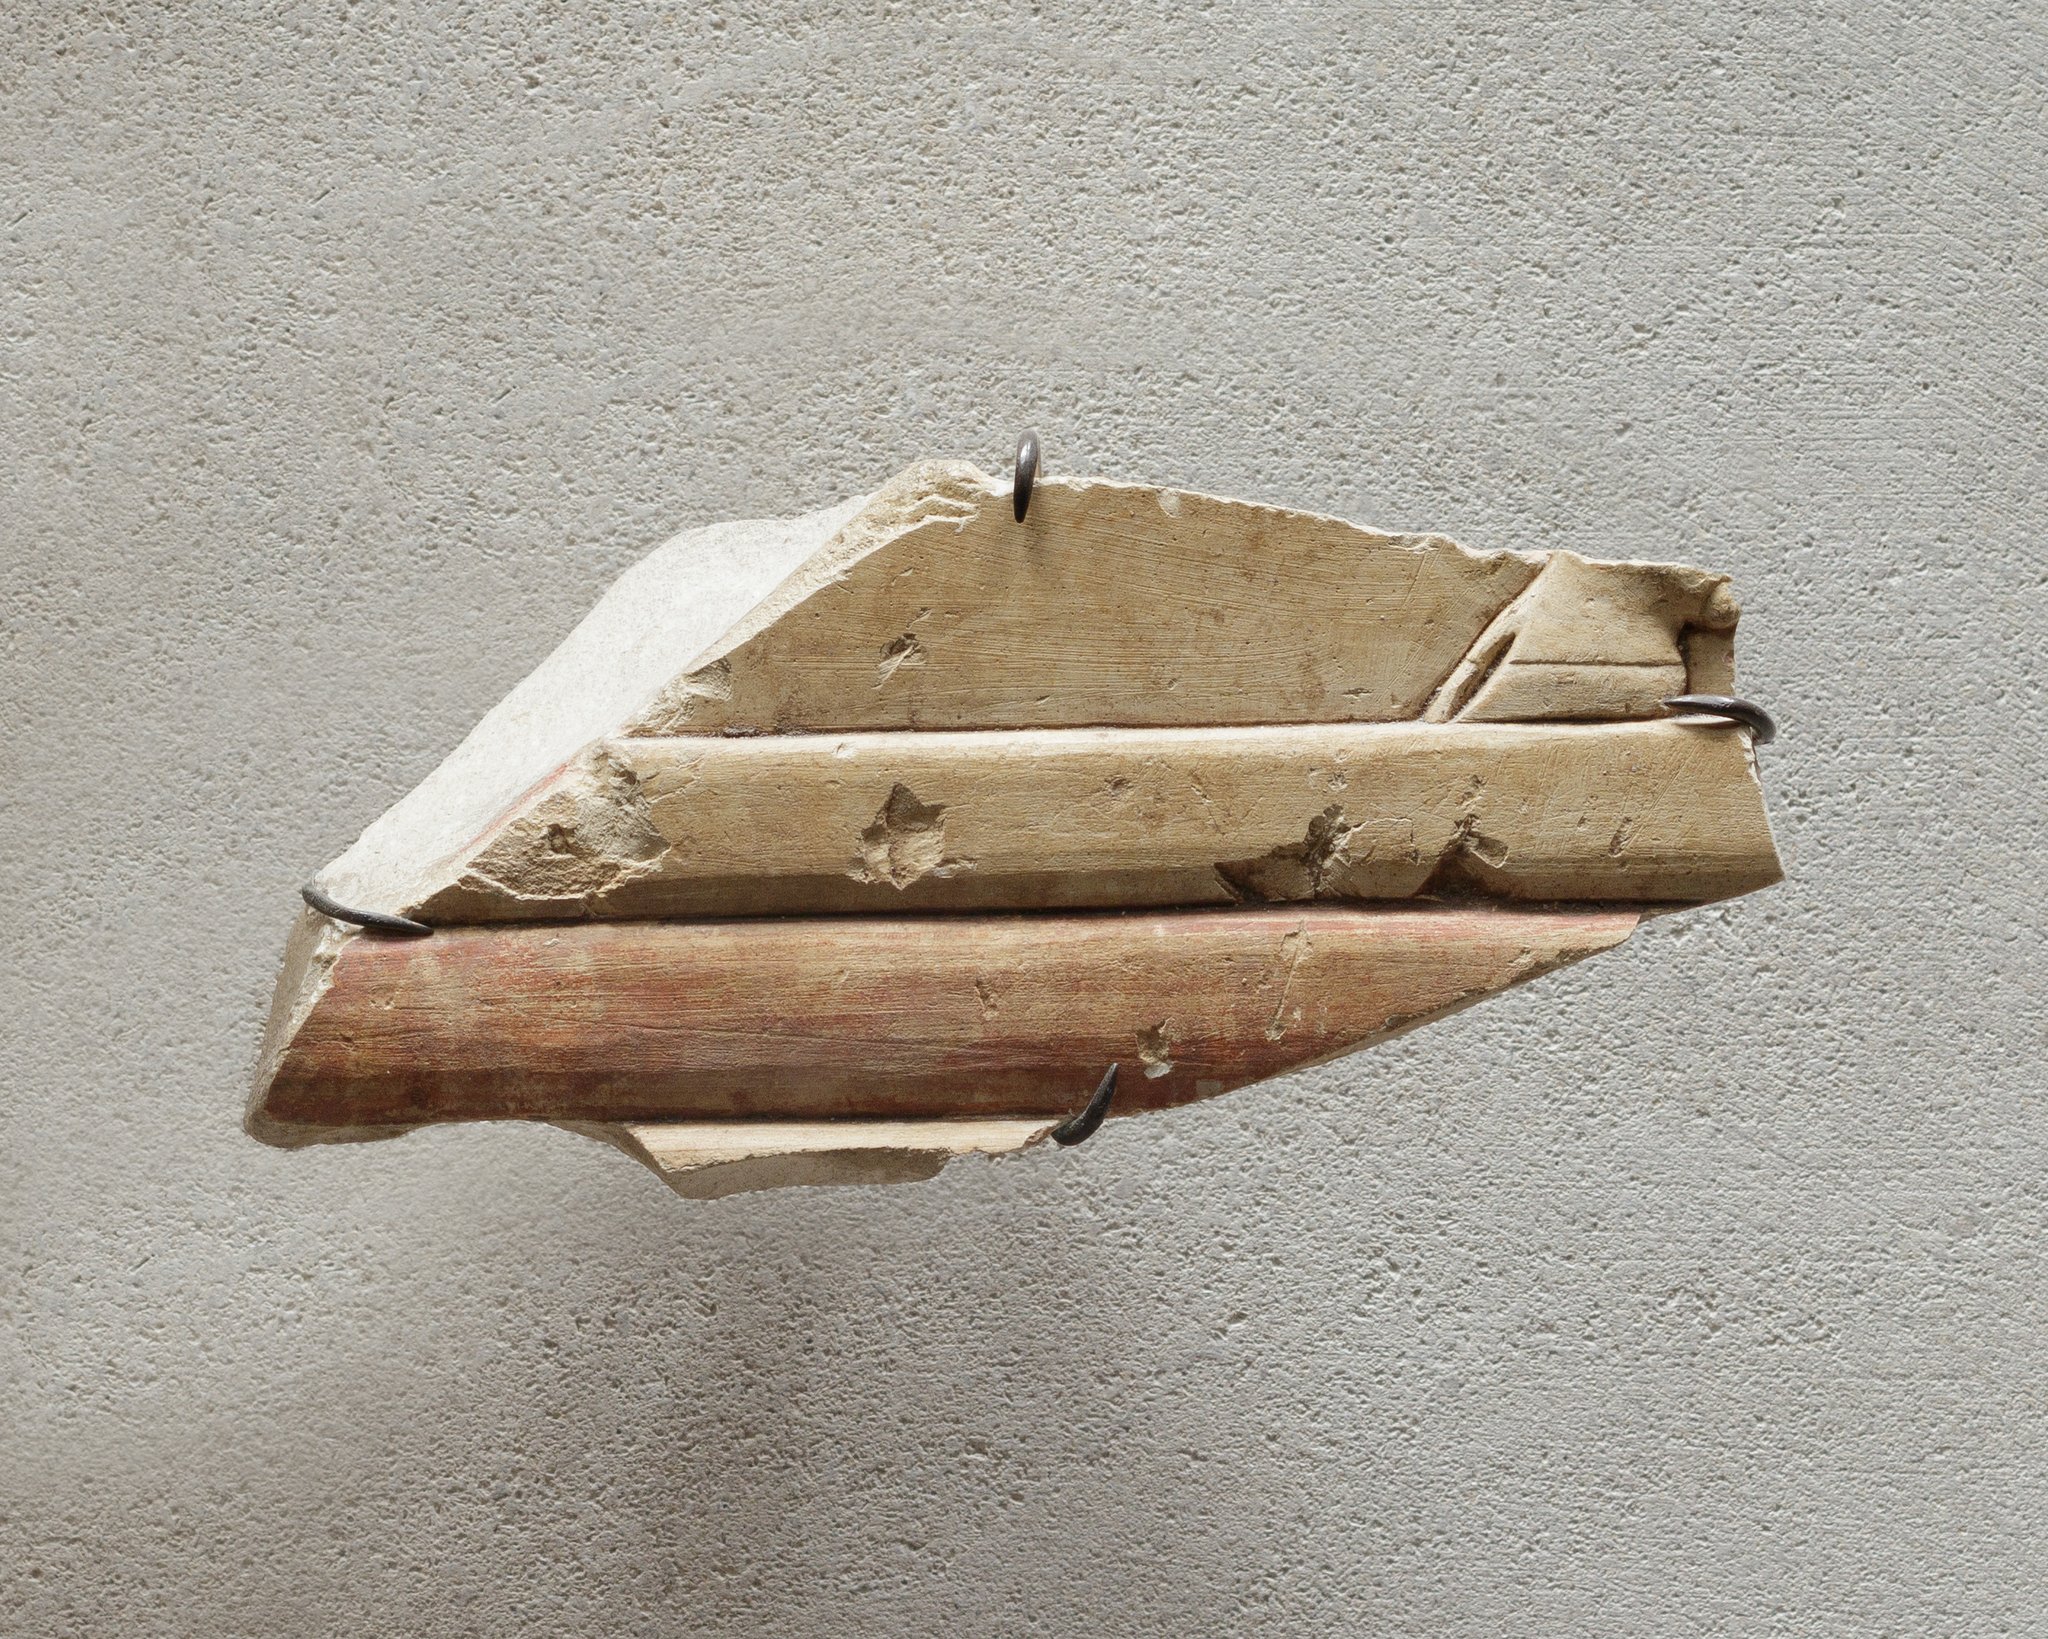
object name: relief fragment, tomb of neferu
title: Relief of the foot of an ox - see 26.3.353-3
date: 2051-2030 BCE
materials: limestone, paint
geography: egypt